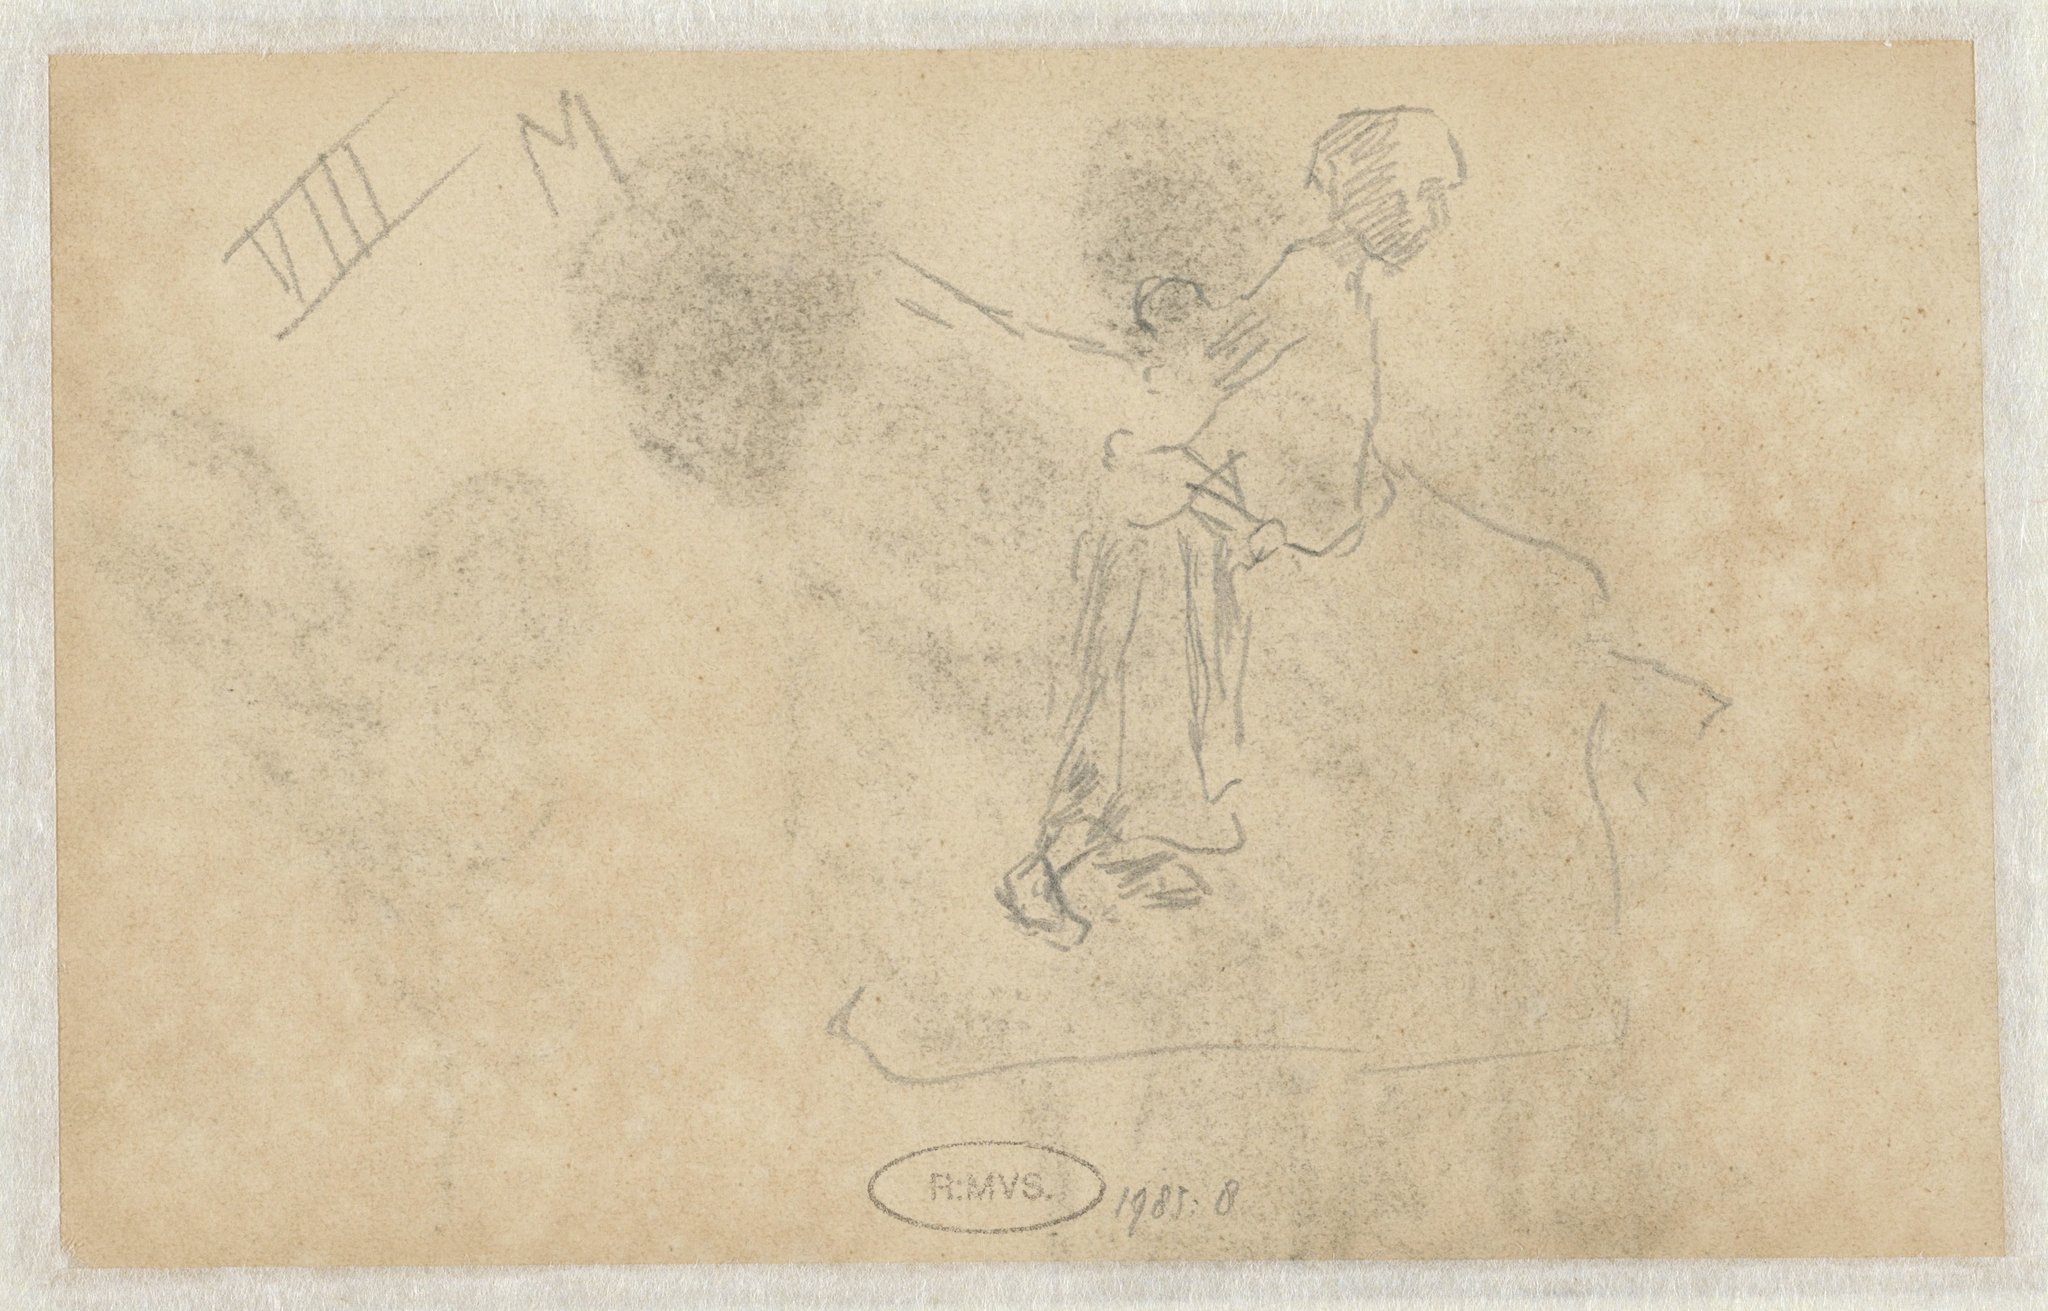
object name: drawing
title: Schets van een lopende vrouw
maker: hendrik johannes haverman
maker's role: draughtsman, print maker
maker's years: 1857-1928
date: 1867-1928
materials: chalk, paper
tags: africans (bedouins)